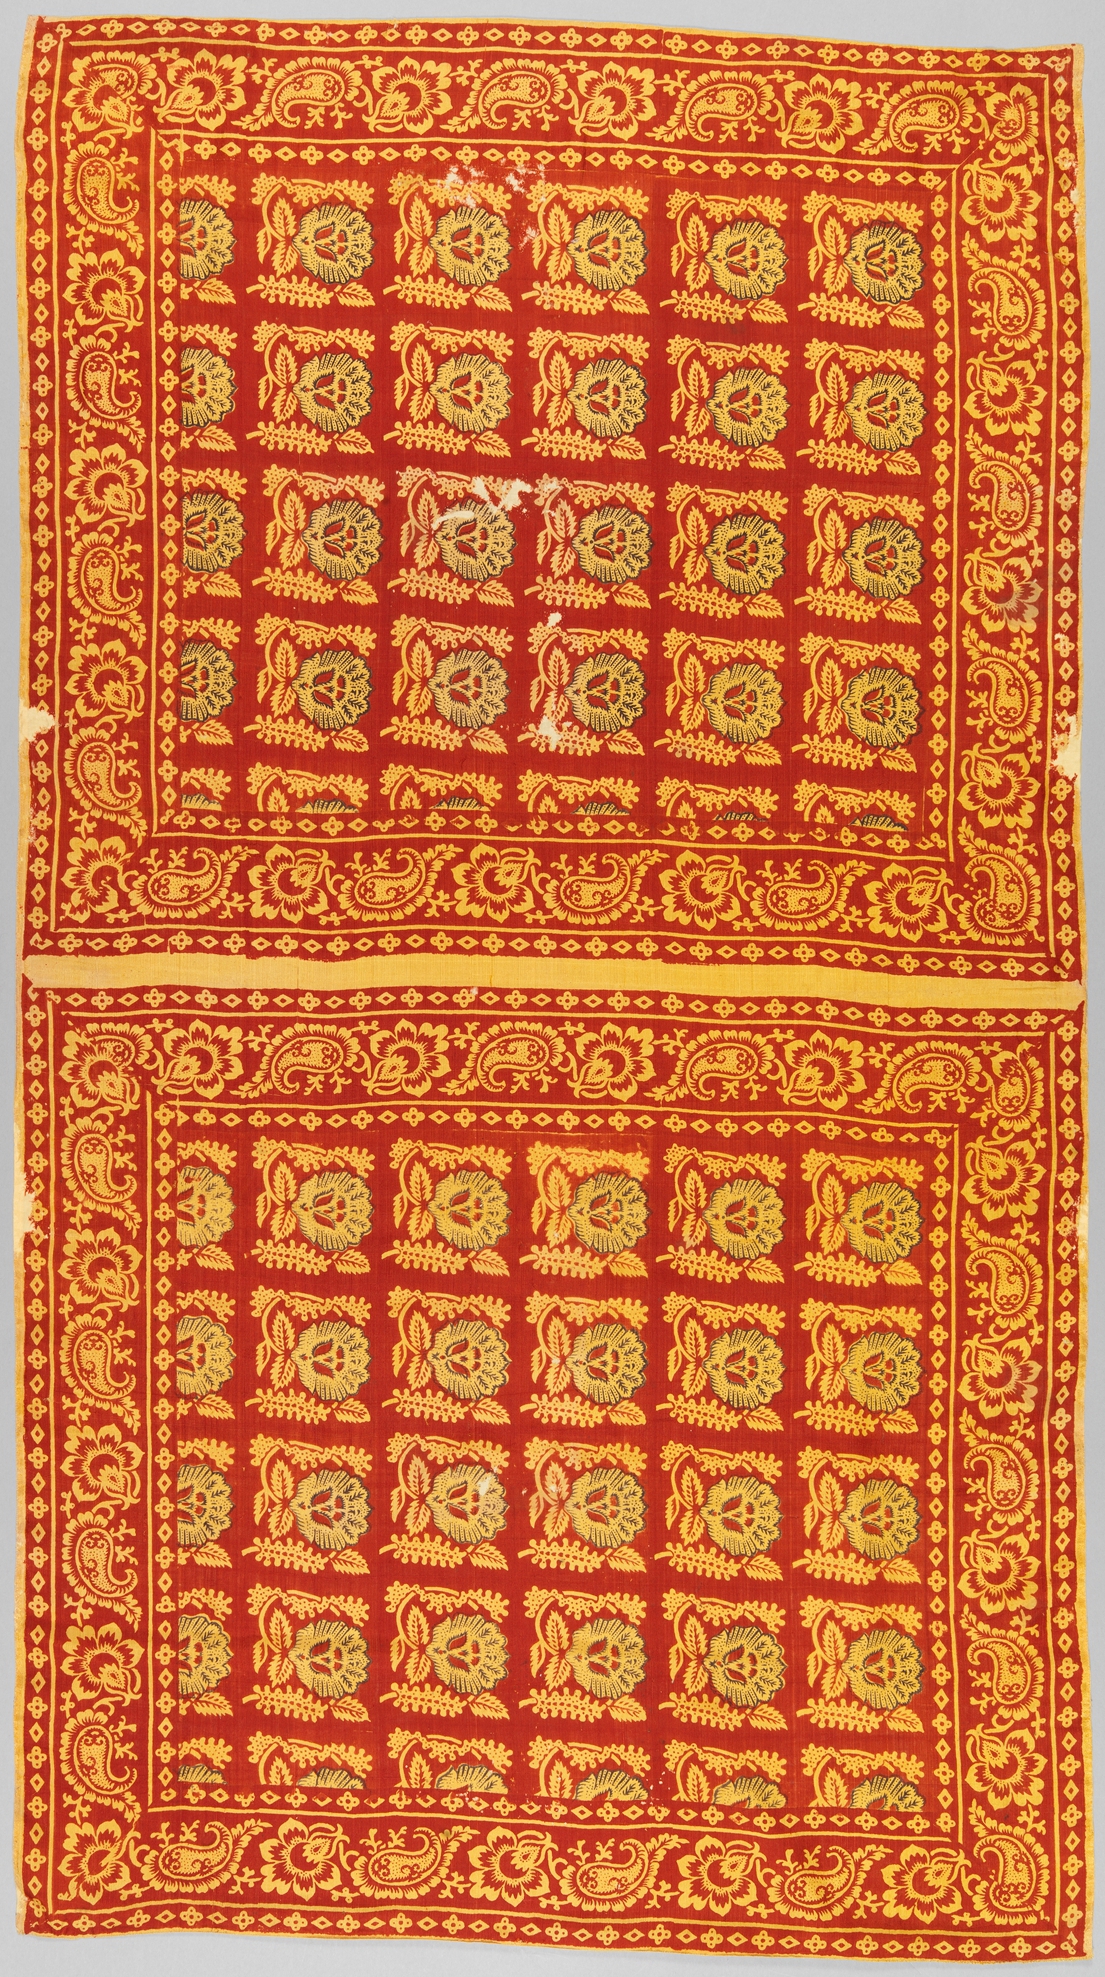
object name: handkerchief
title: Man's handkerchief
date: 1801-1900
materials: silk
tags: flowers